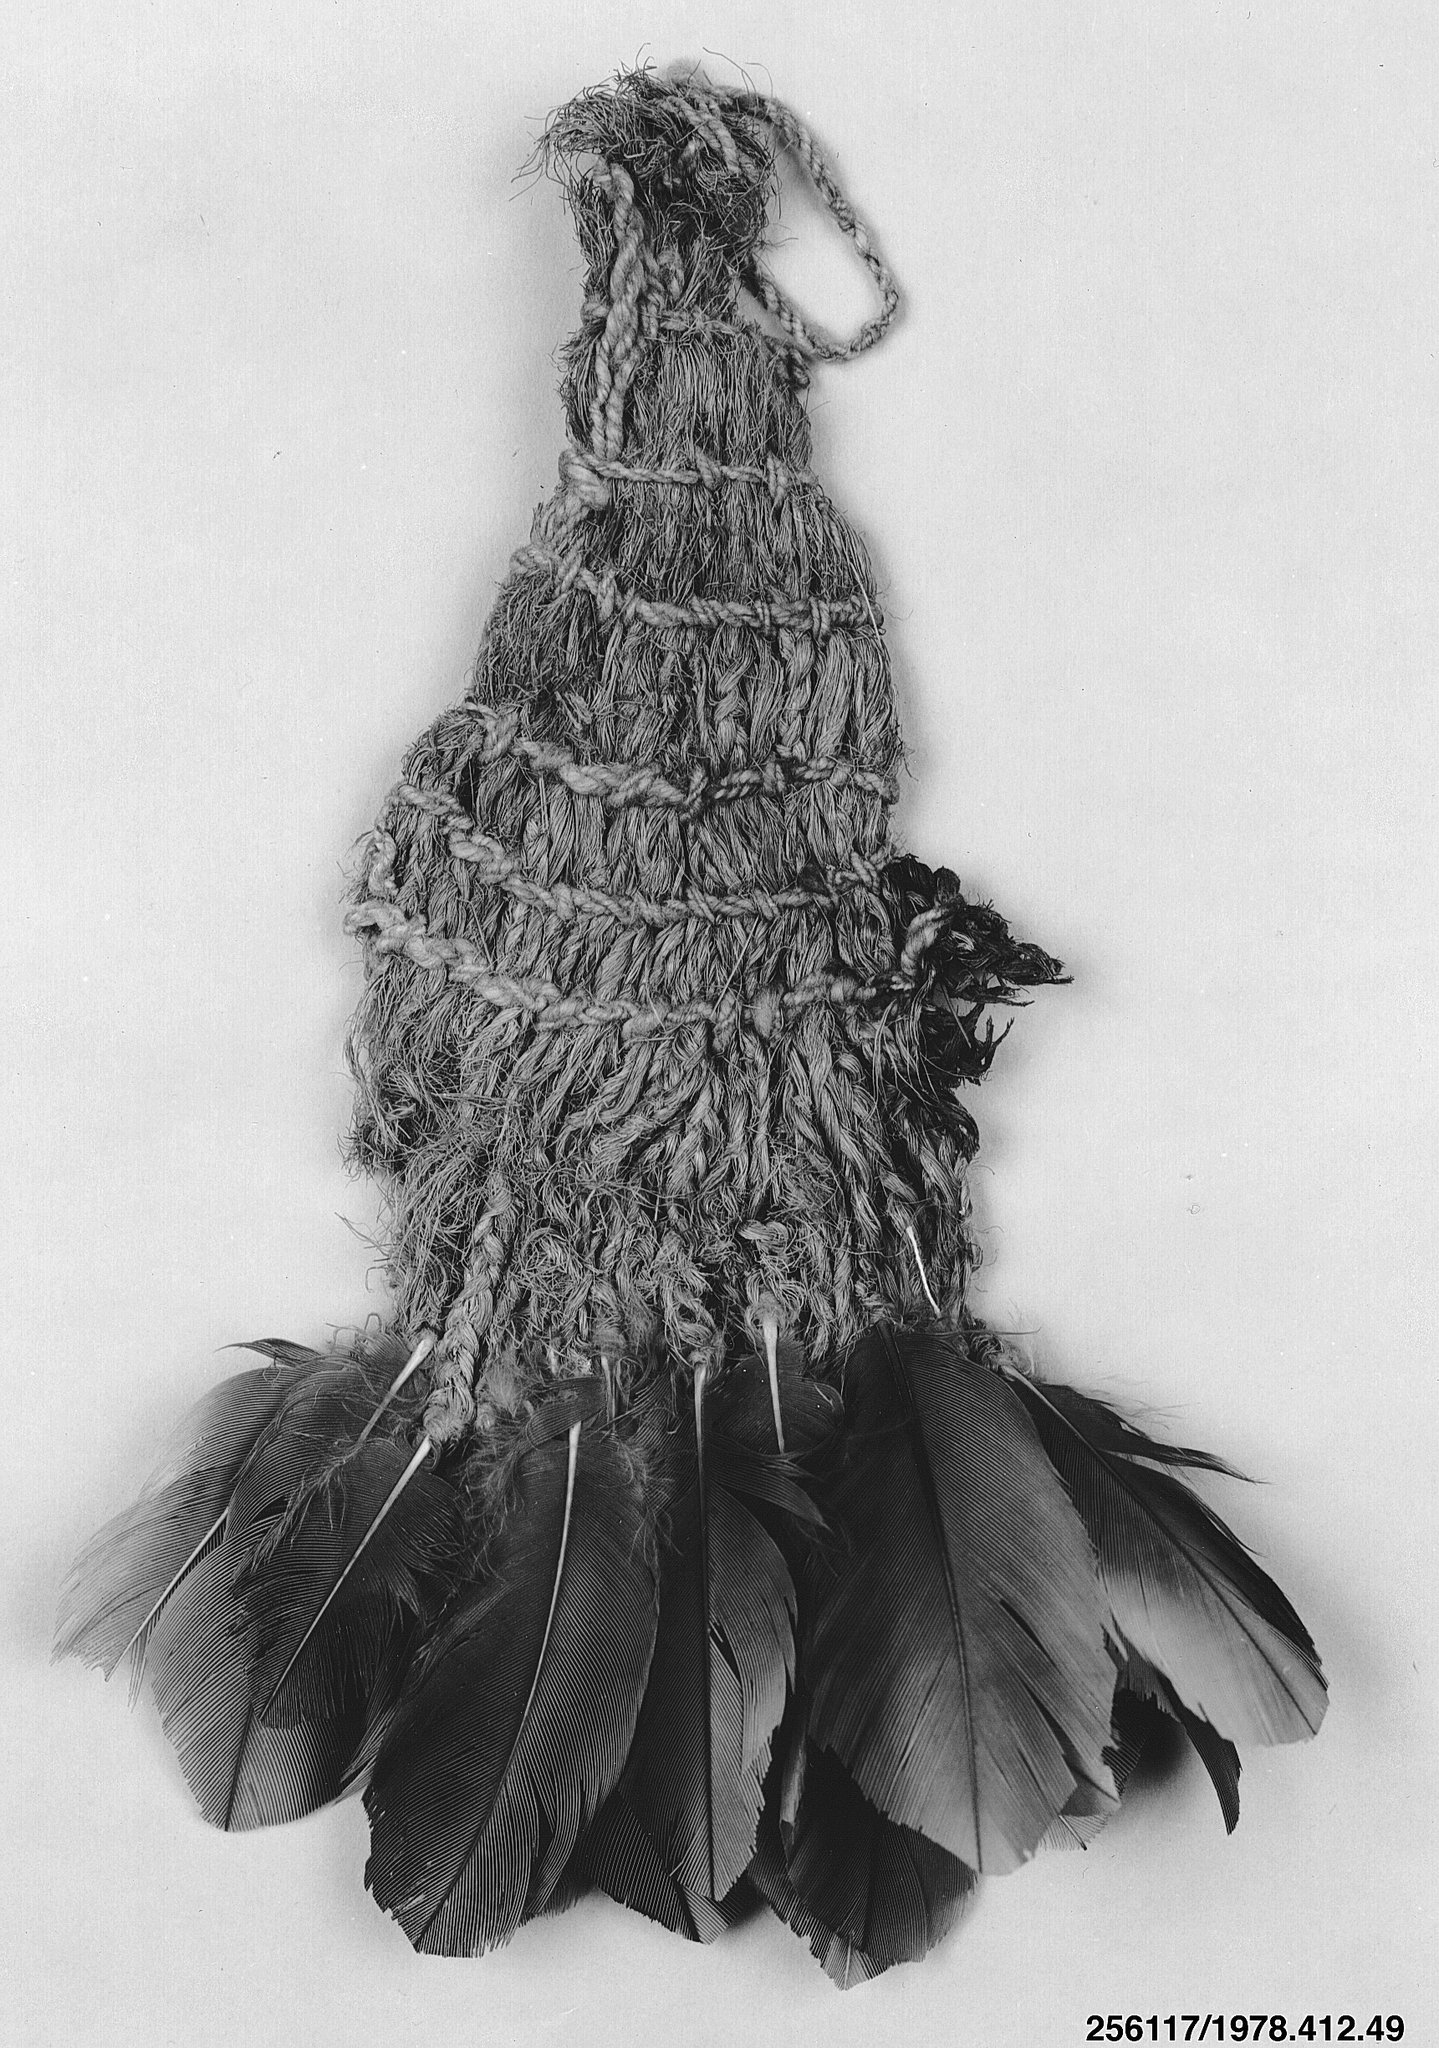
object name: ornament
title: Feathered Ornament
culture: central or south coast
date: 1001-1500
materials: cotton, feather, fiber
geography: peru